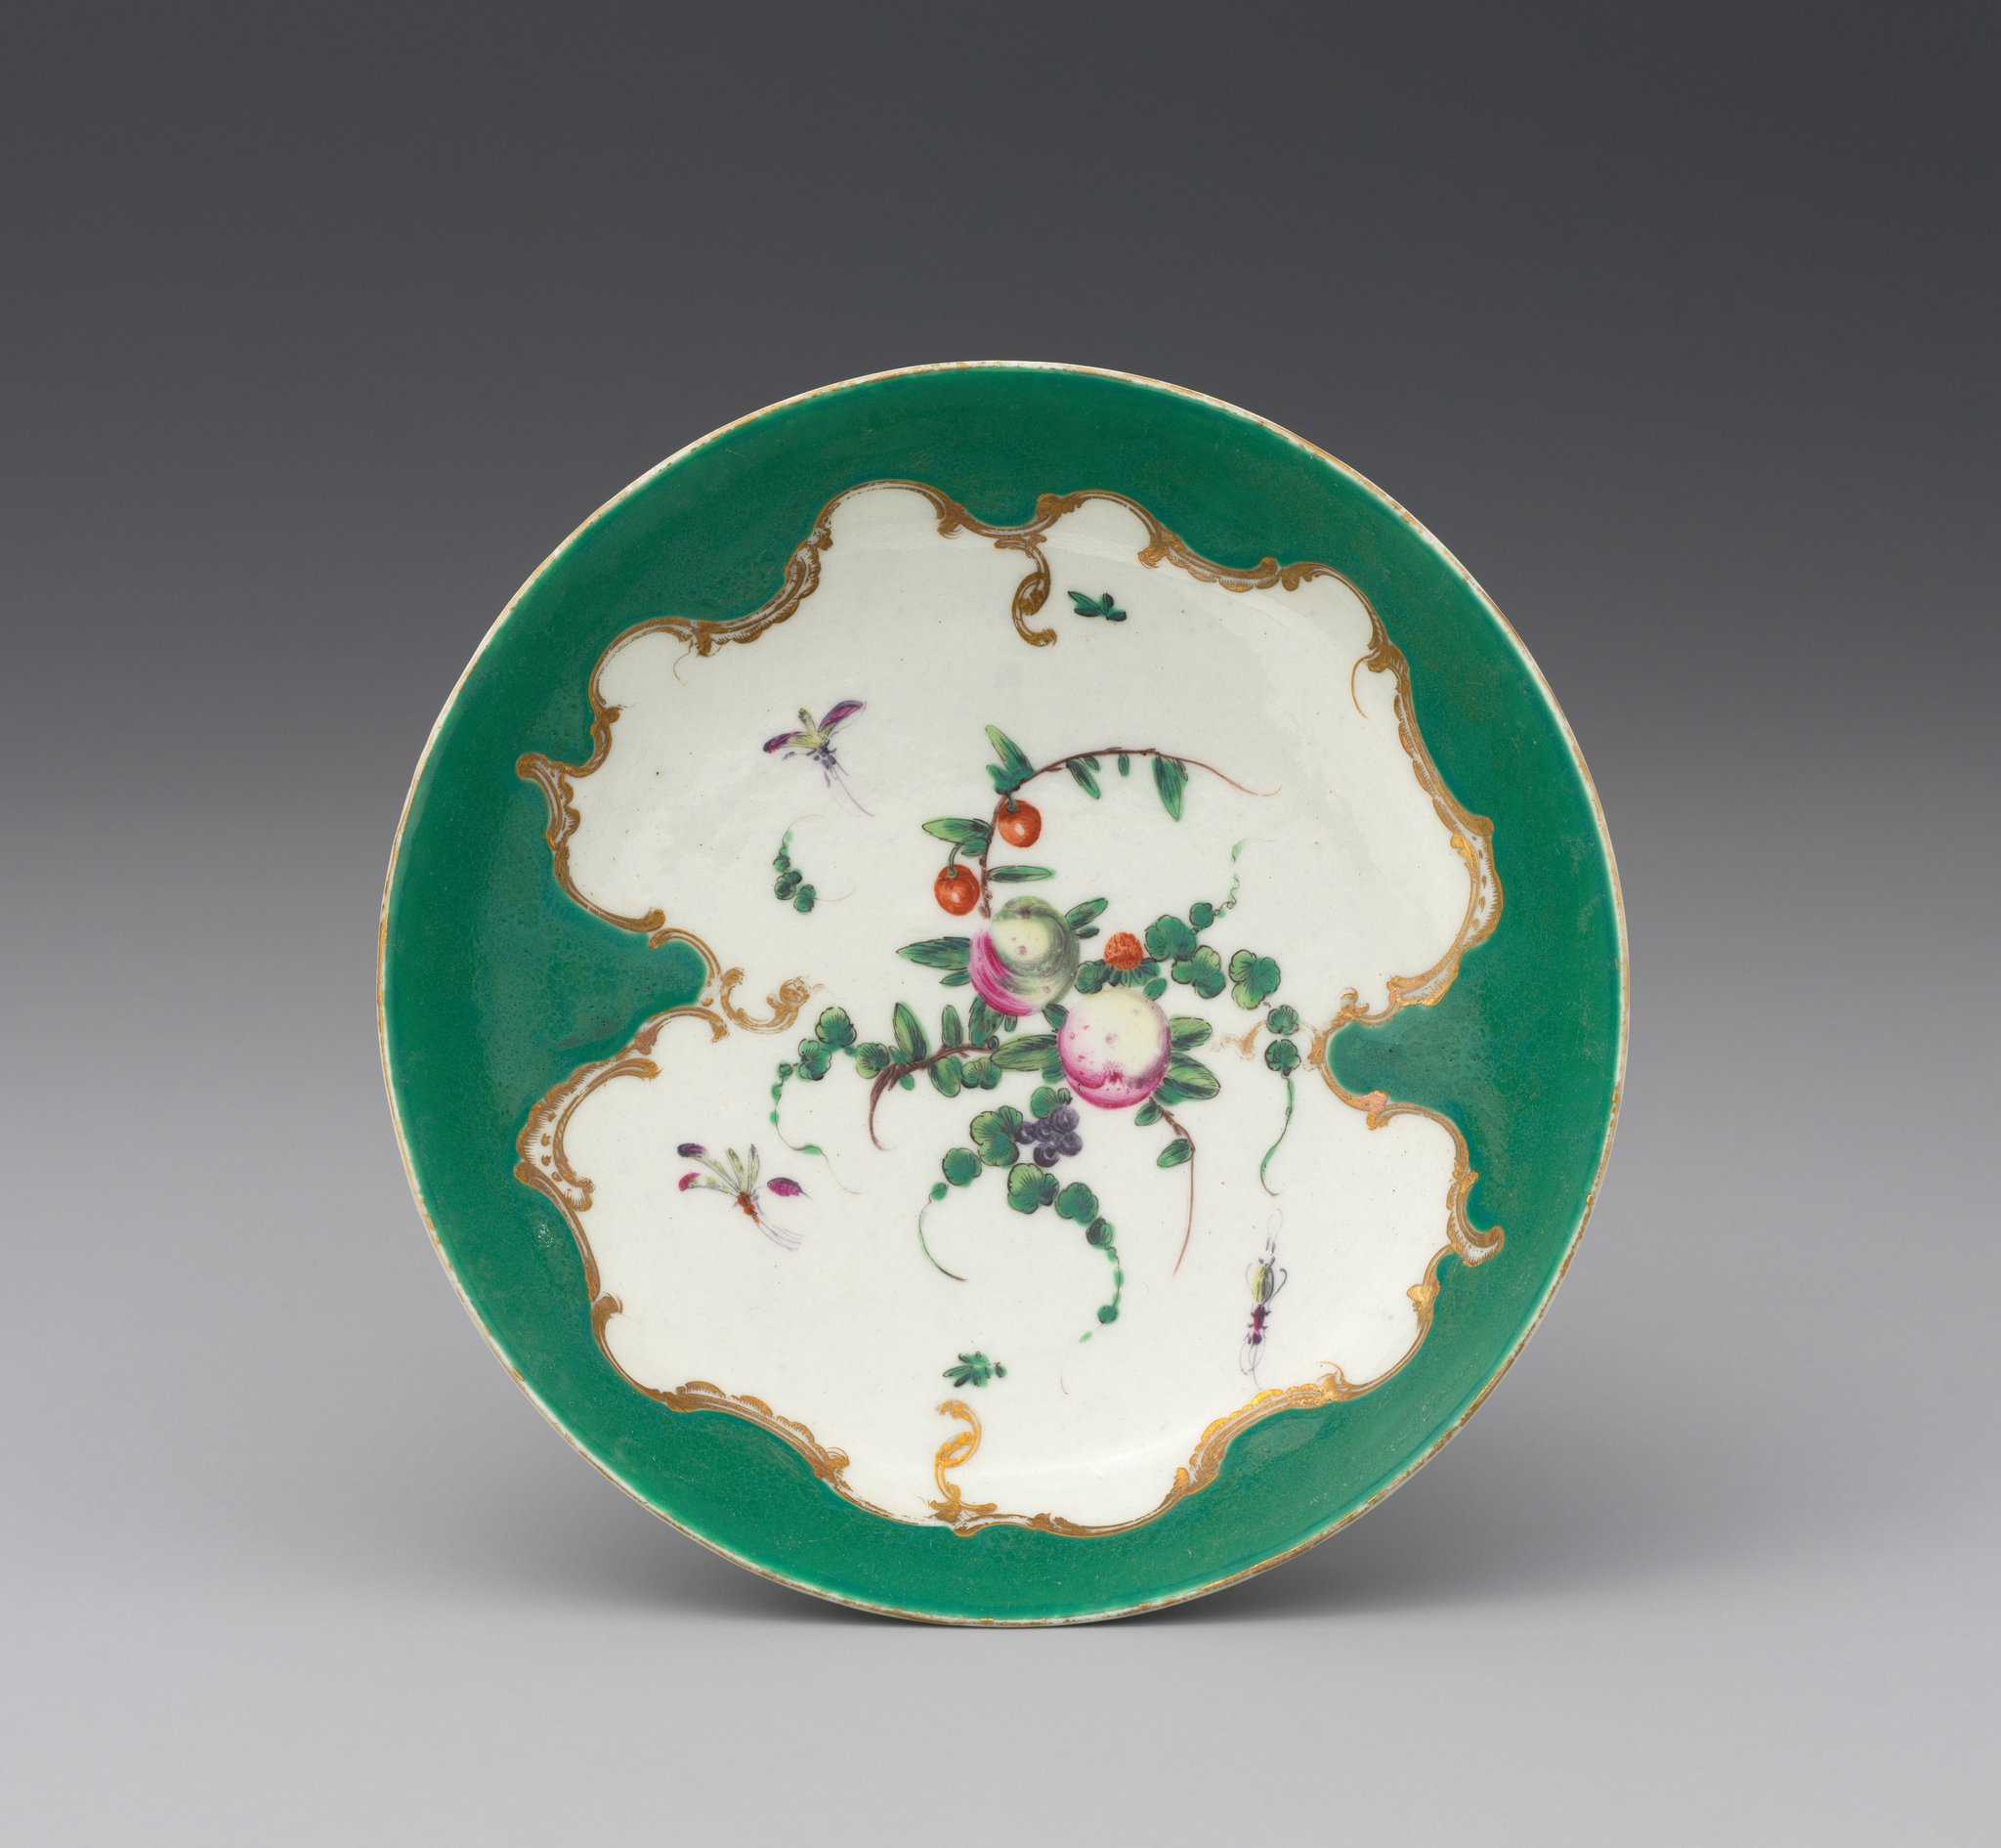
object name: saucer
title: Saucer (part of a service)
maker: worcester factory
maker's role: factory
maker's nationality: british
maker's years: 1751-2008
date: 1770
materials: soft paste porcelain